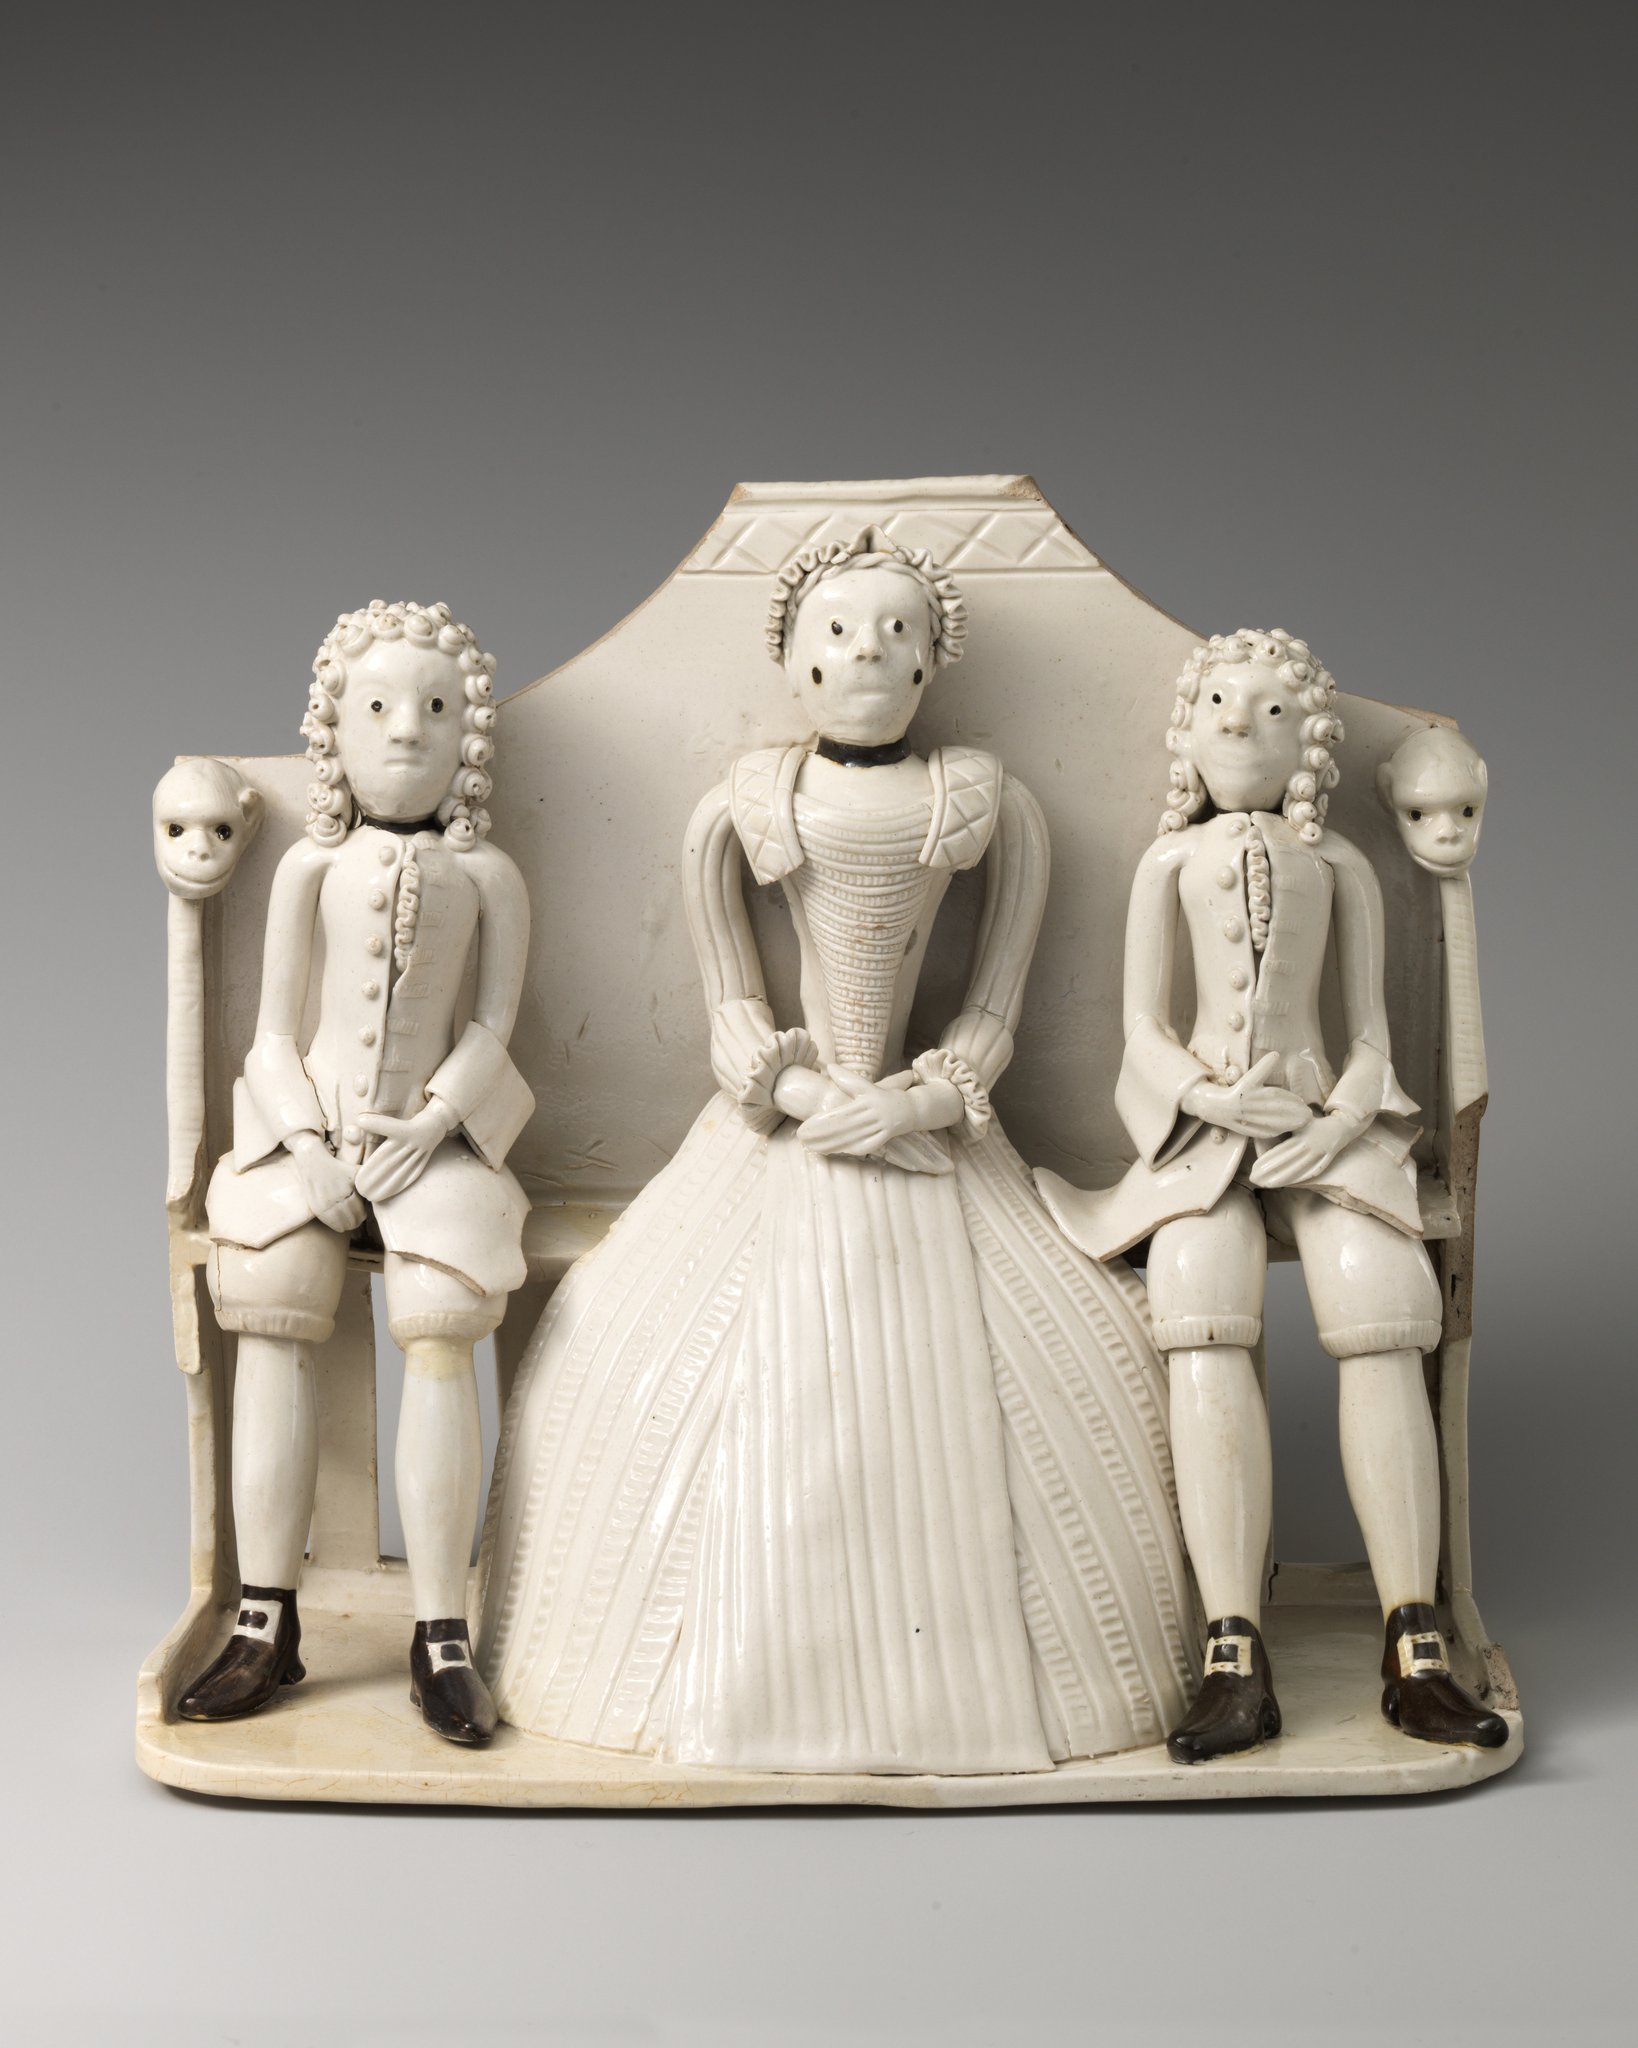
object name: figure group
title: Pew group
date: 1745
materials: stoneware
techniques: salt glaze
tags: children,women